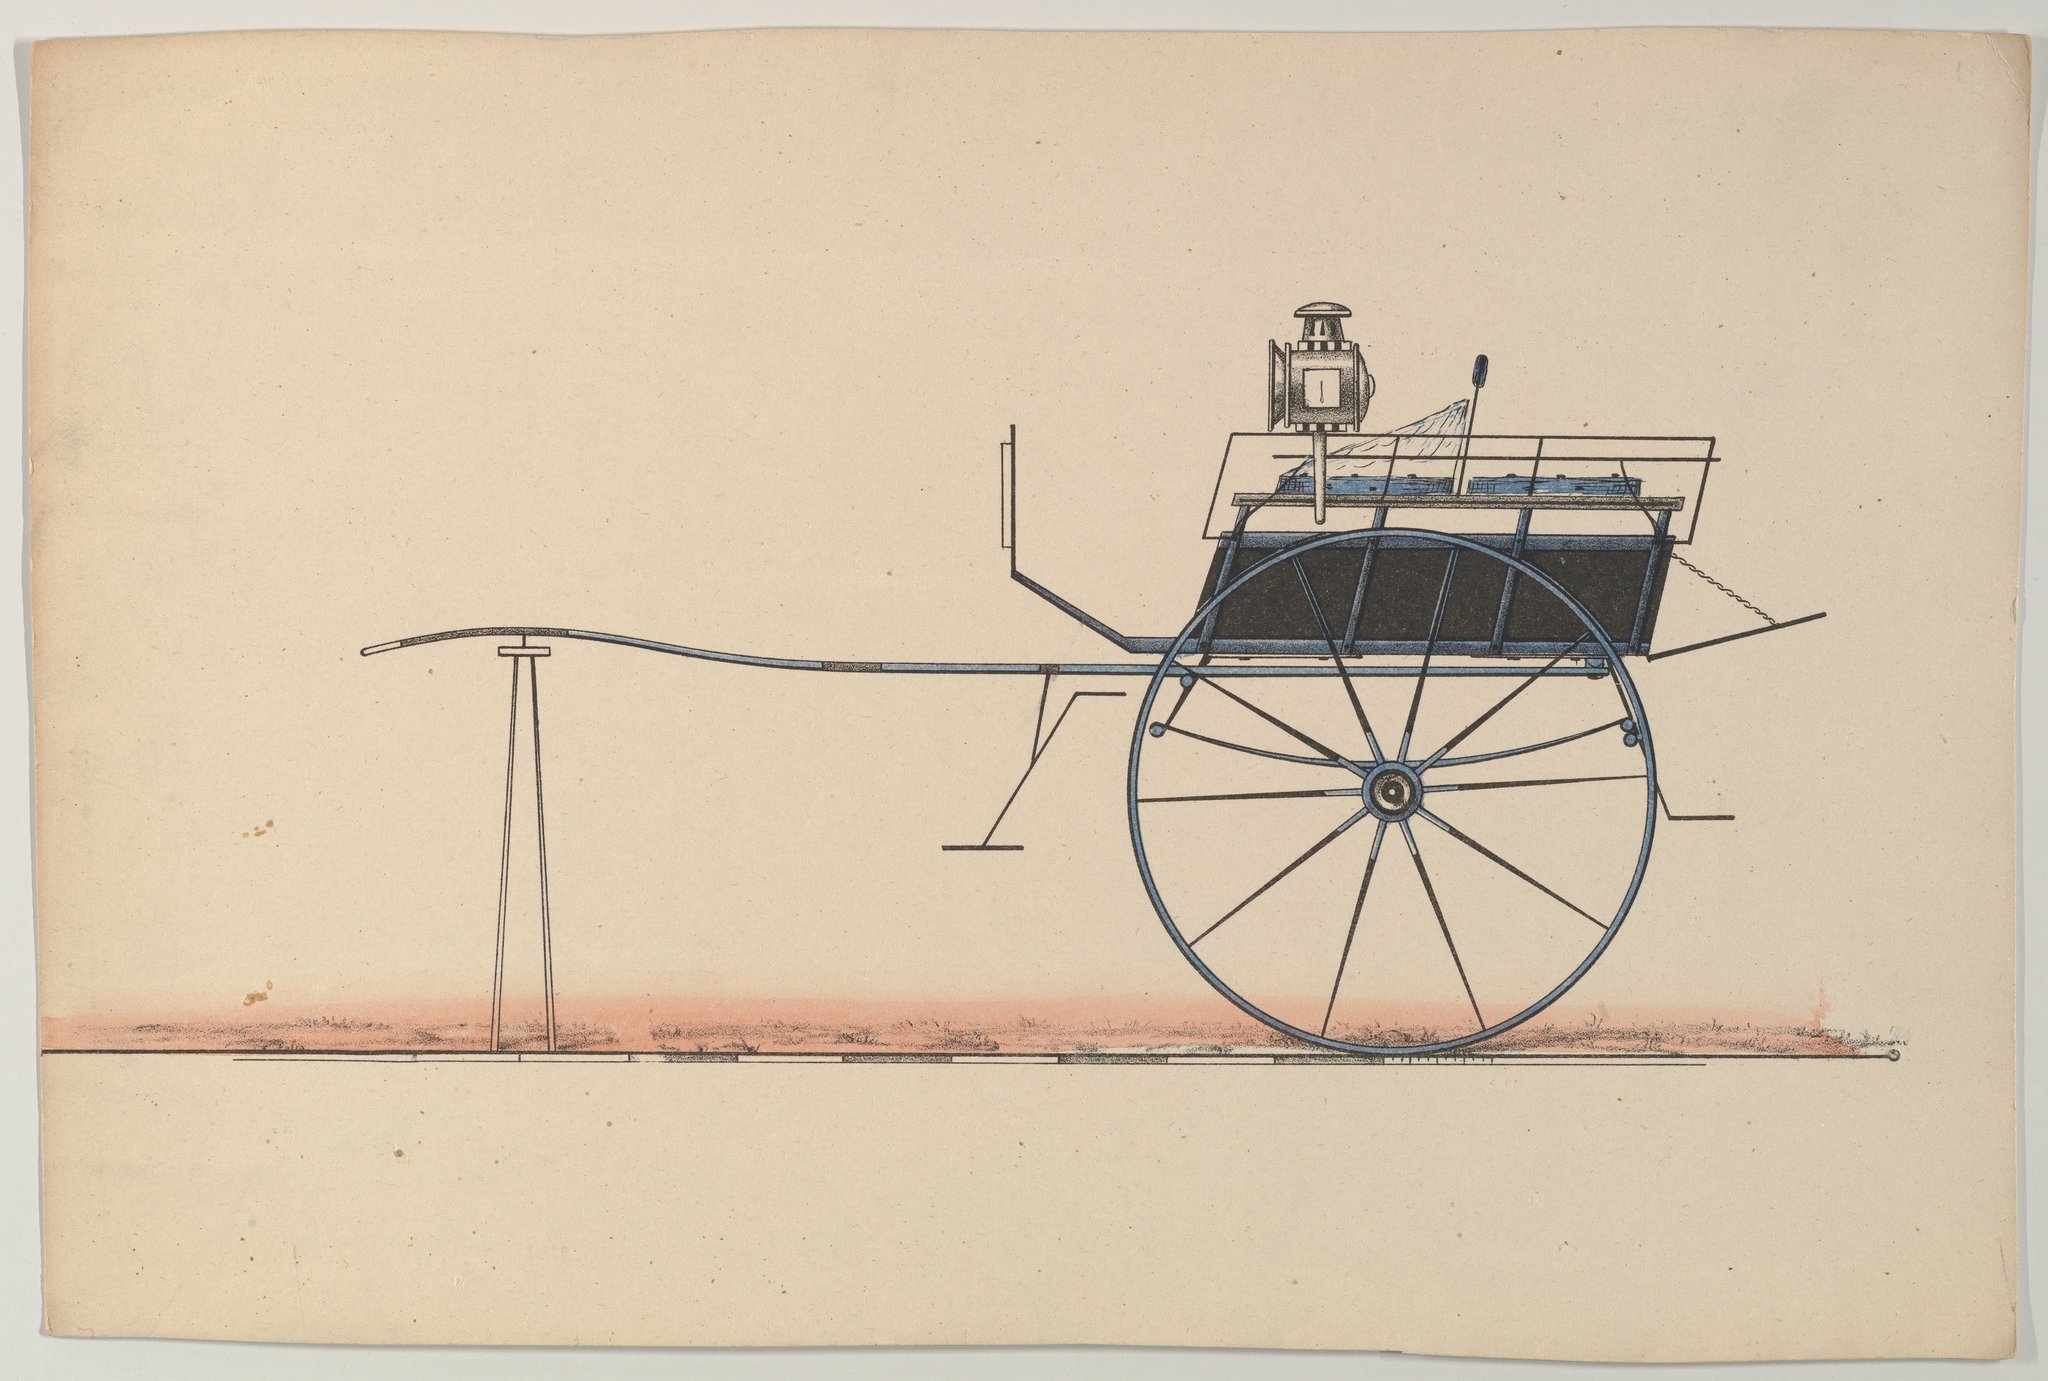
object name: print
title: Dog Cart (unnumbered)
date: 1850-1874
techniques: lithograph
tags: carriages